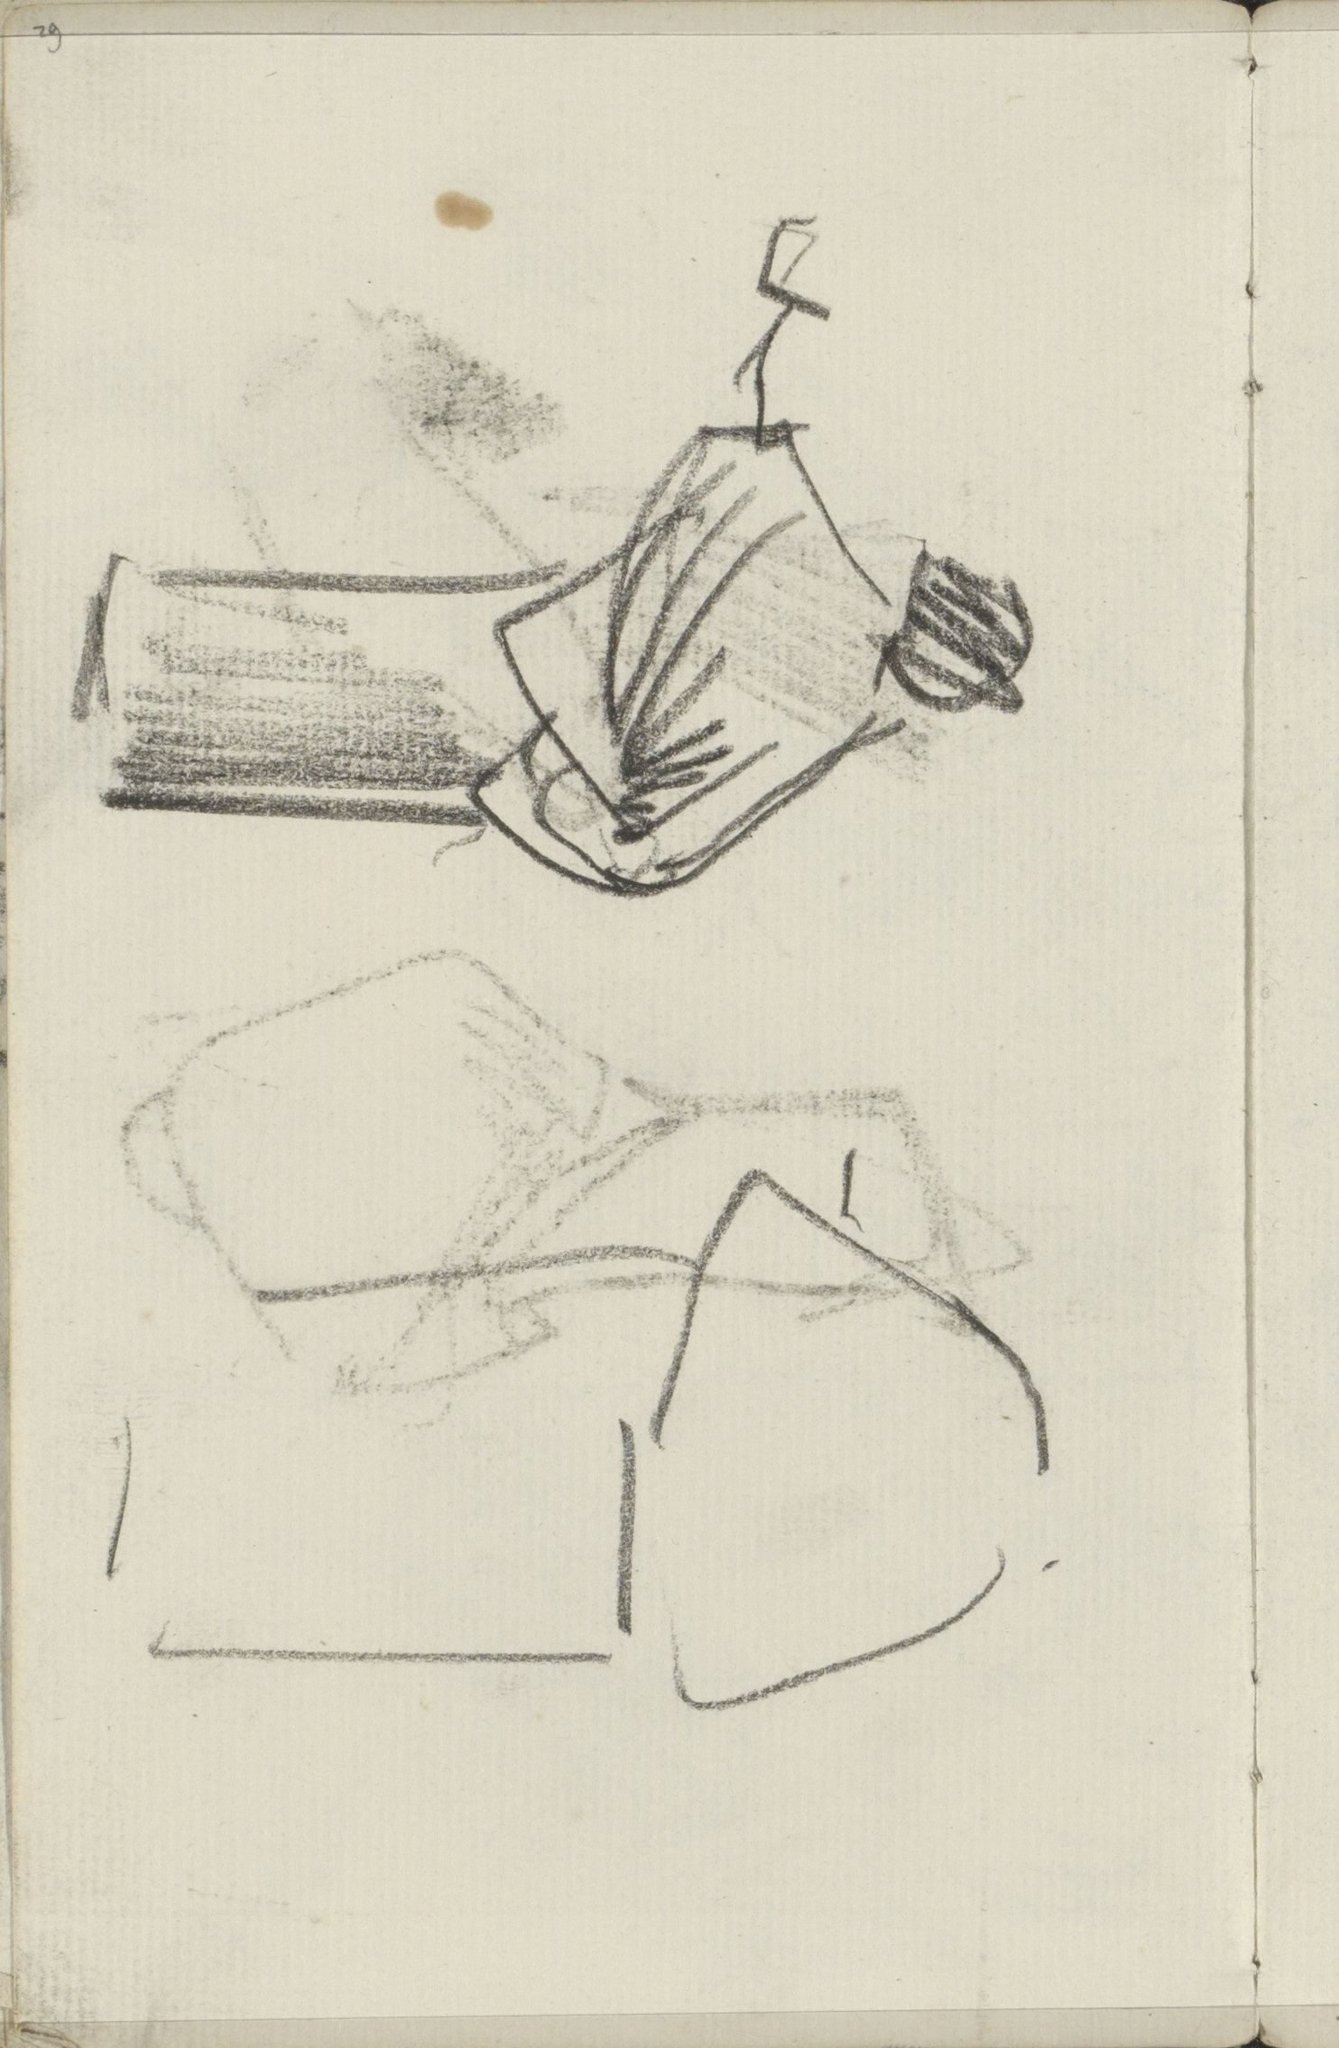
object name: sketchbook leaf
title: Figuurstudies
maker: george hendrik breitner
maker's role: draughtsman, painter, print maker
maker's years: 1857-1923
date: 1884-1886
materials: chalk, paper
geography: paris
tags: standing figure - aa - female human figure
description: Onder andere een vrouw met een omslagdoek. Pagina 29 uit een schetsboek met 25 bladen.